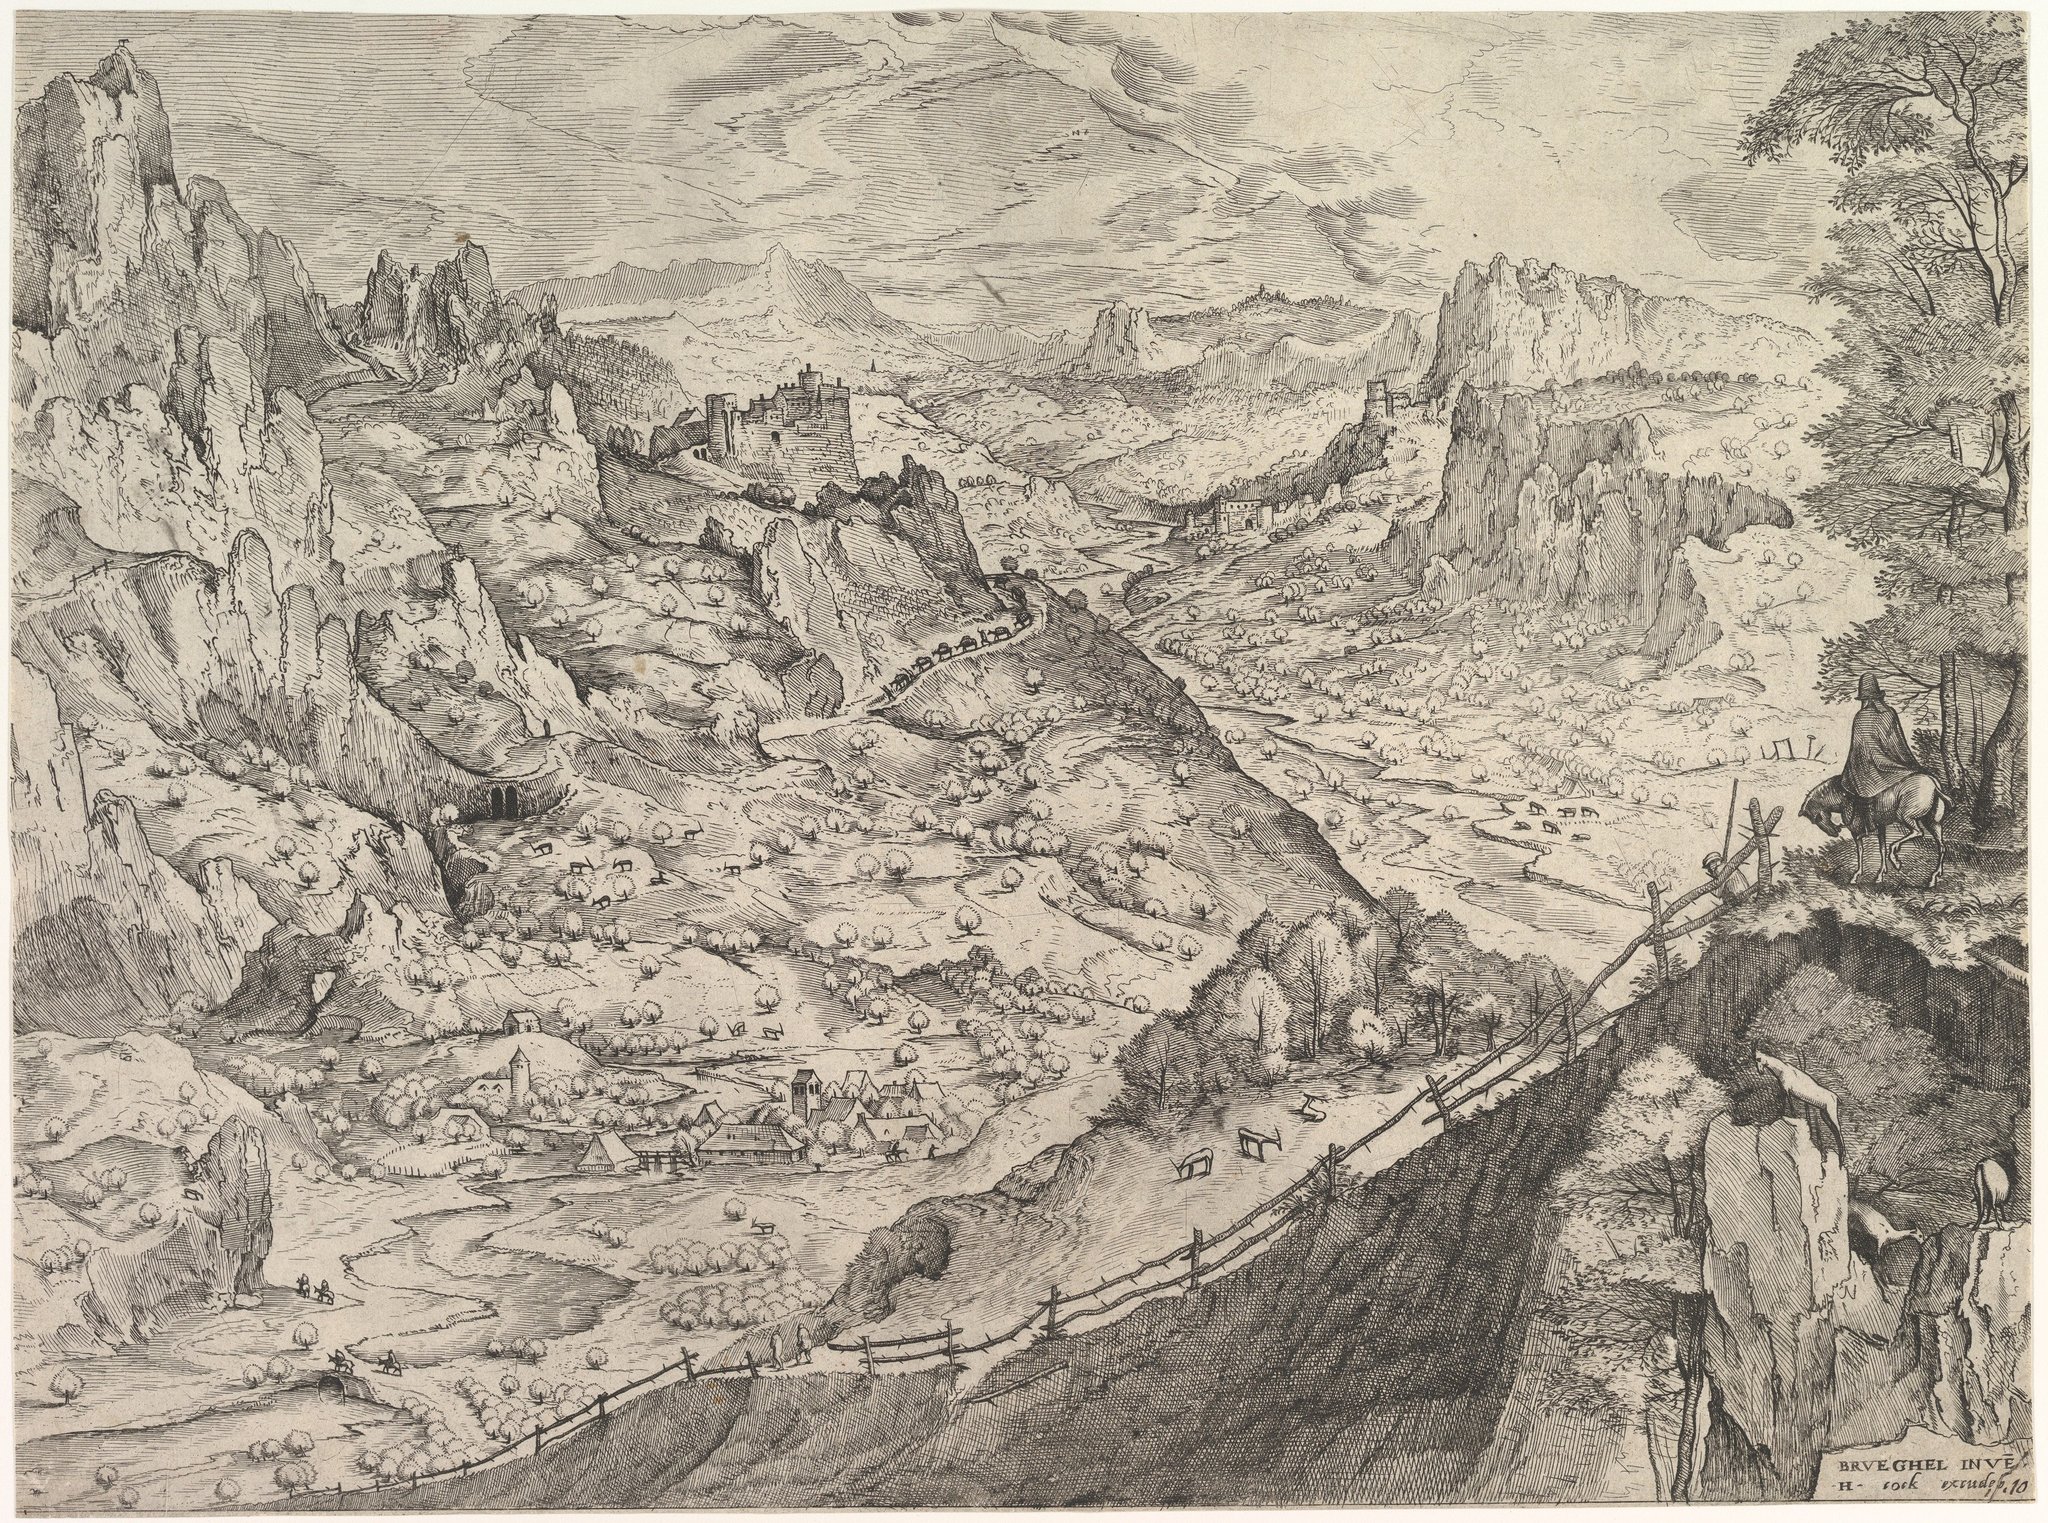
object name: print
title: Large Alpine Landscape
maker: johannes van doetecum i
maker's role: artist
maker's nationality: netherlandish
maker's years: 1528-1605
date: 1555-1556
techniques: engraving, etching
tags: mountains,landscapes